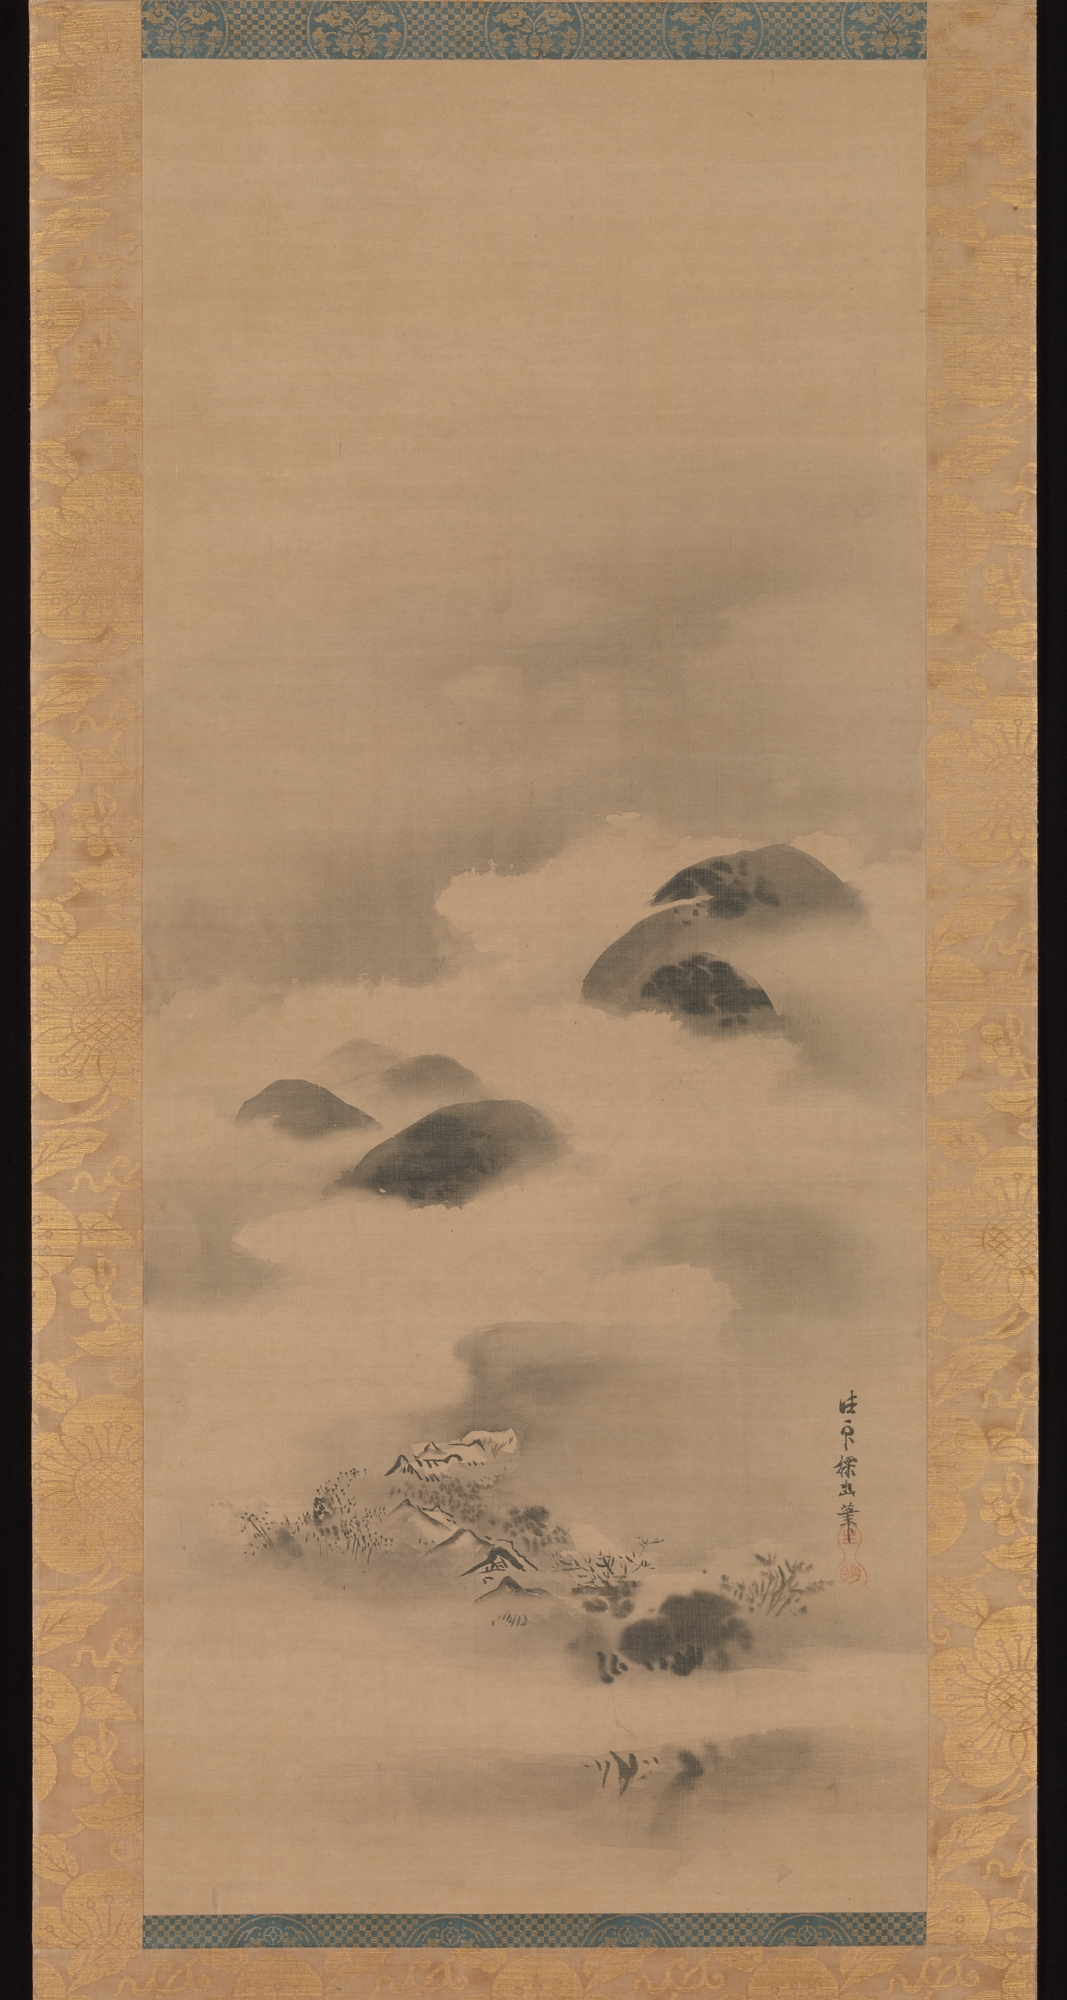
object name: hanging scroll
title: Landscape in Moonlight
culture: japanese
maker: kano tan'yū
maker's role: artist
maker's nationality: japanese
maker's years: 1602-1674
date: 1662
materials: ink, silk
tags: landscapes